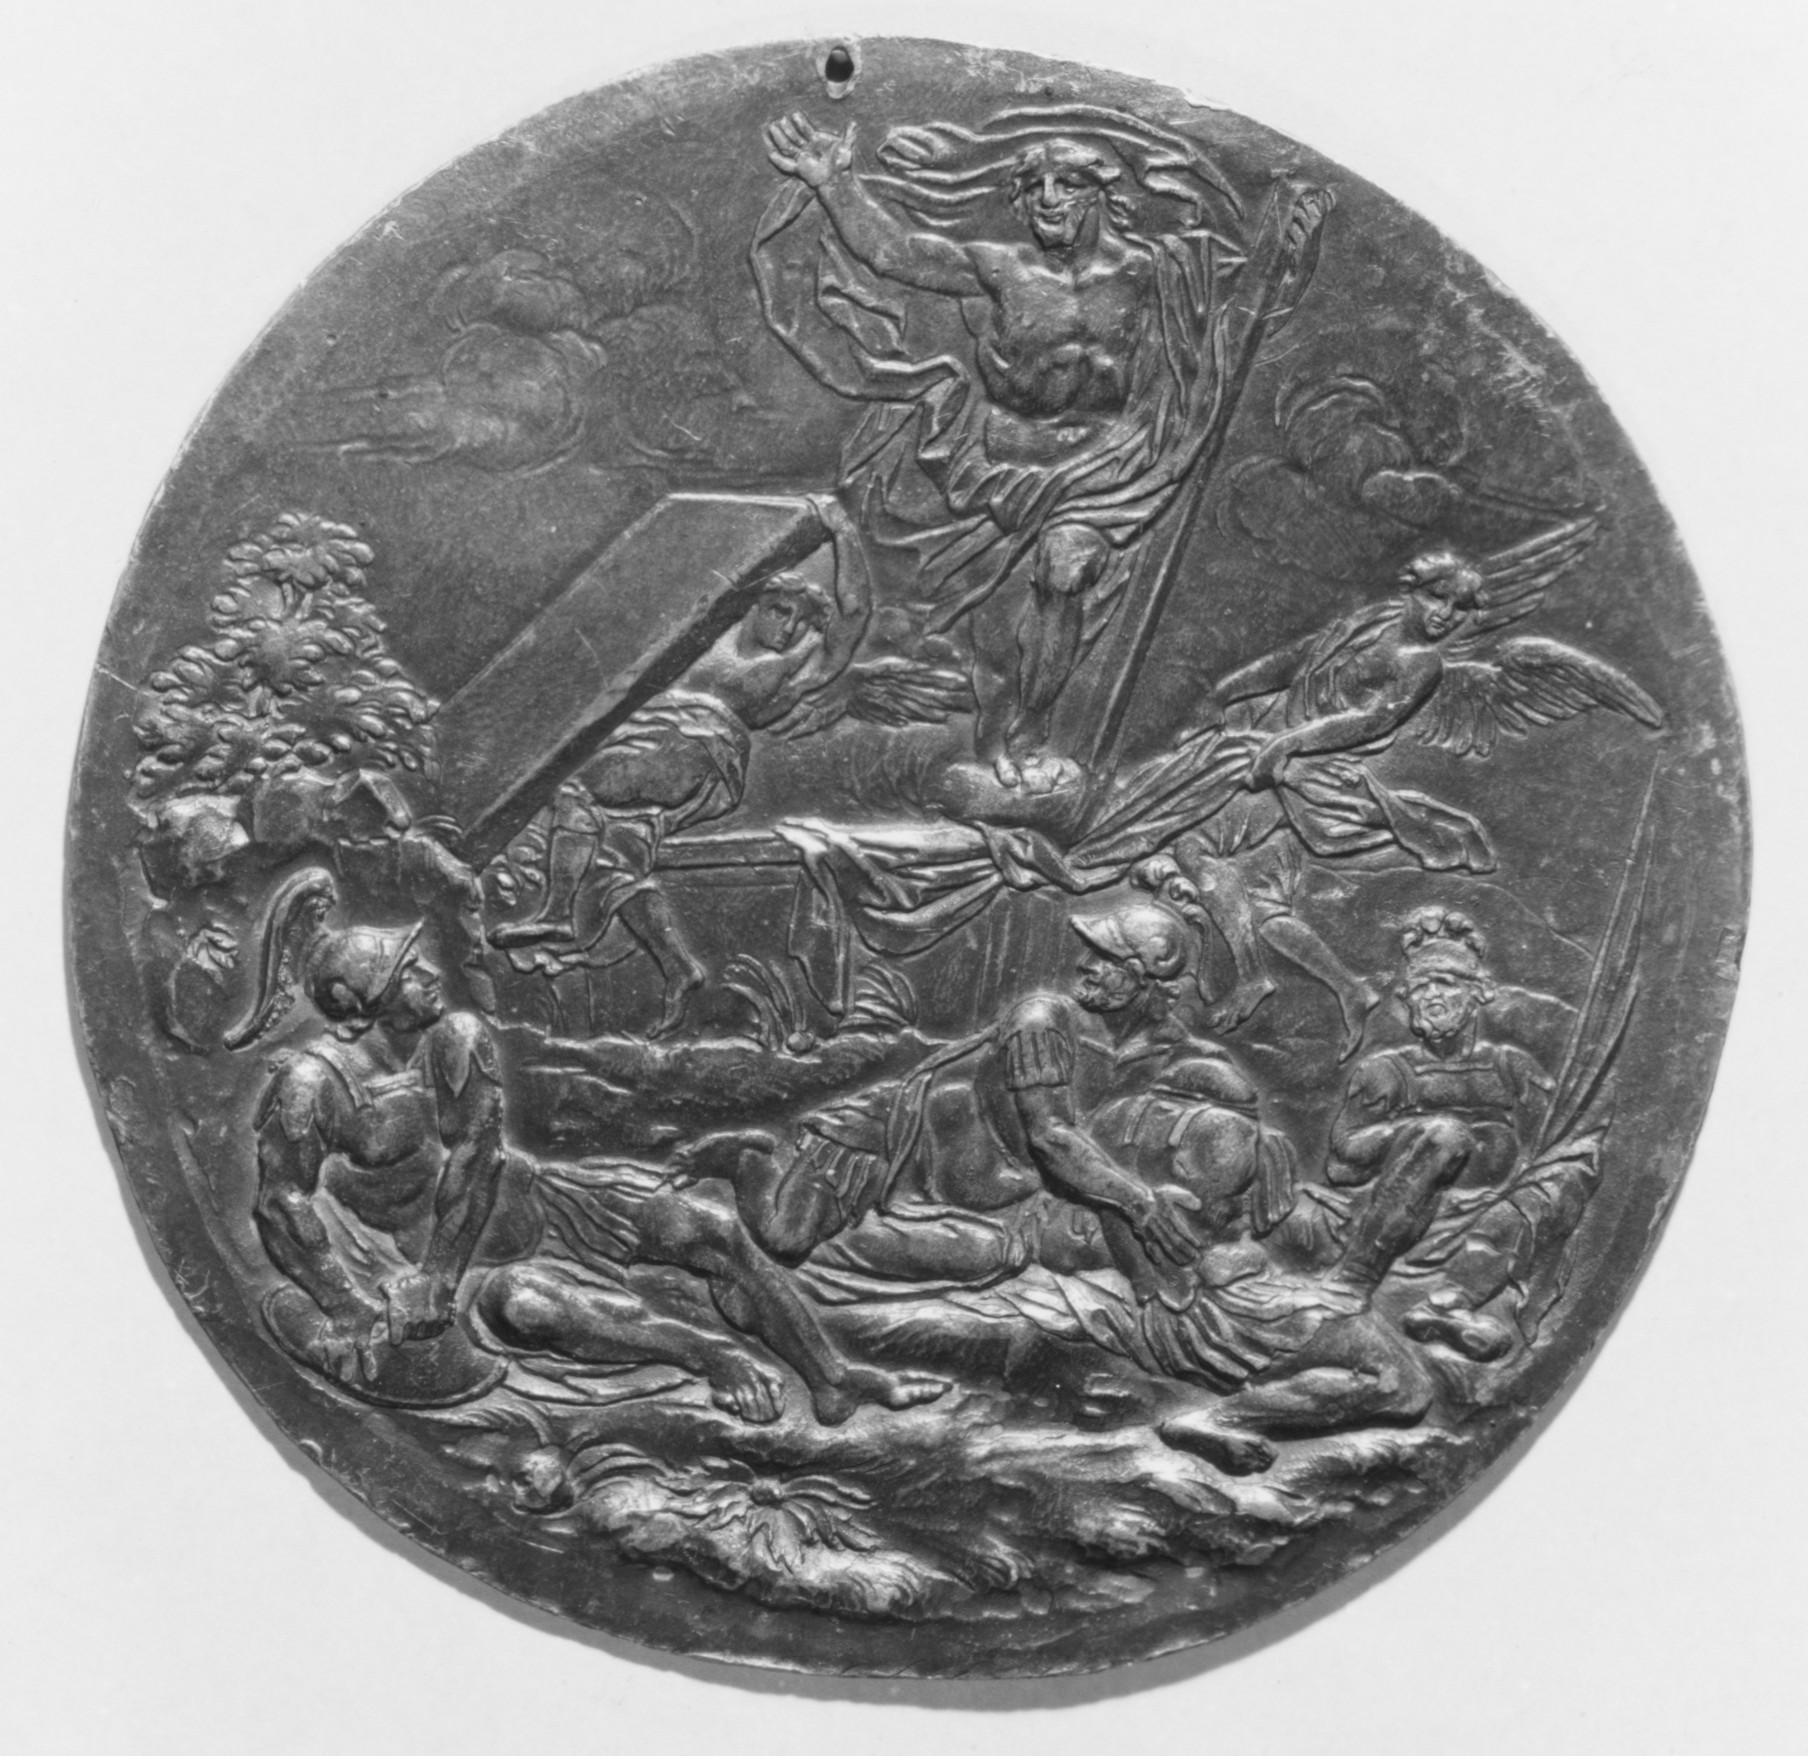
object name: plaquette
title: The Resurrection of Christ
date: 1601-1700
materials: lead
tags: angels,christ